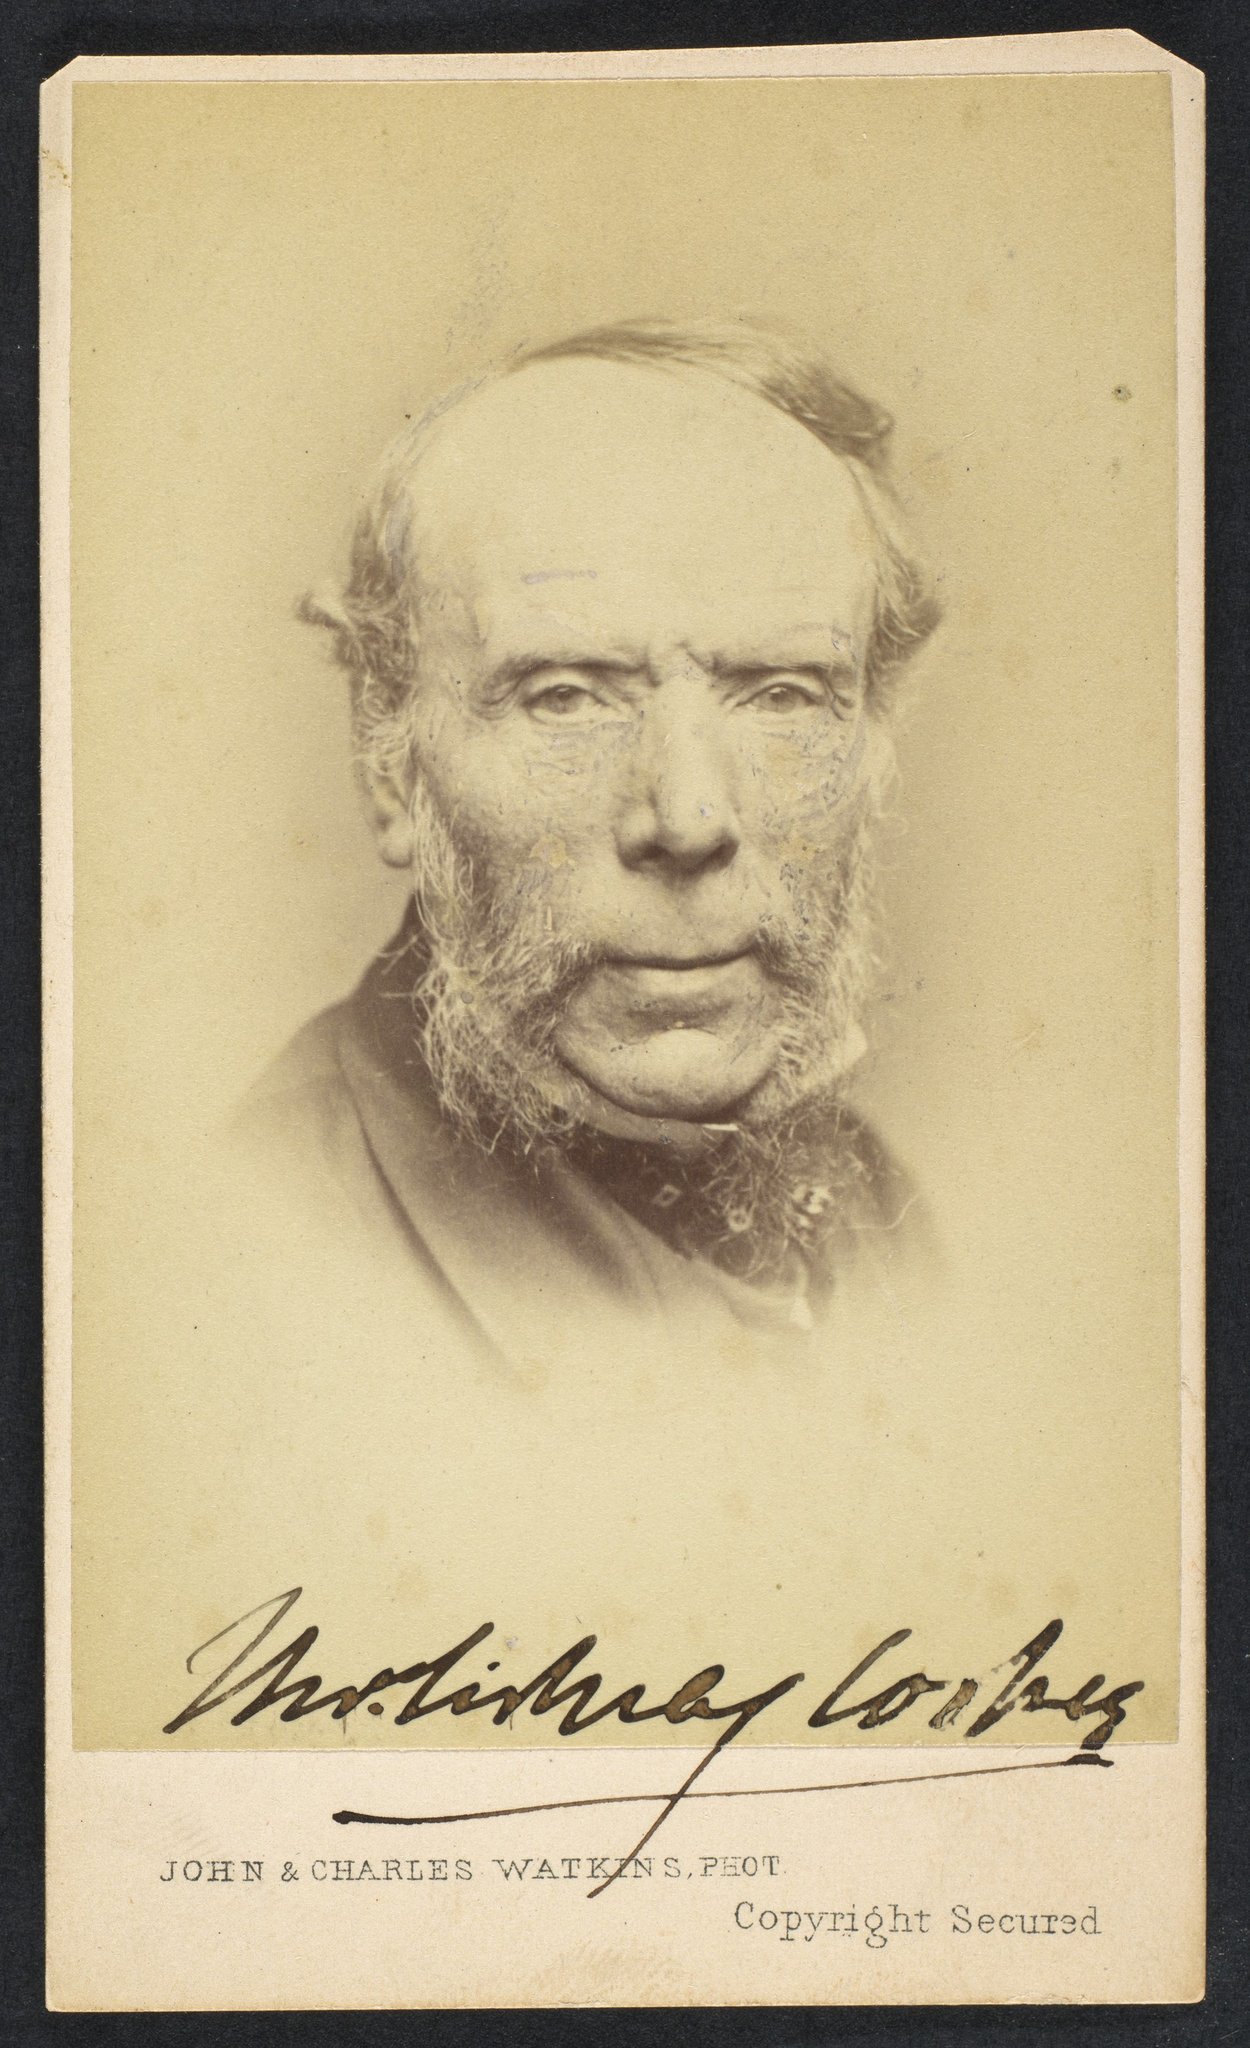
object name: carte de visite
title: [Thomas Sidney Cooper]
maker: john and charles watkins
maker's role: photography studio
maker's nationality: british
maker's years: 1840-1875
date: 1860-1869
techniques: albumen silver print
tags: men,portraits